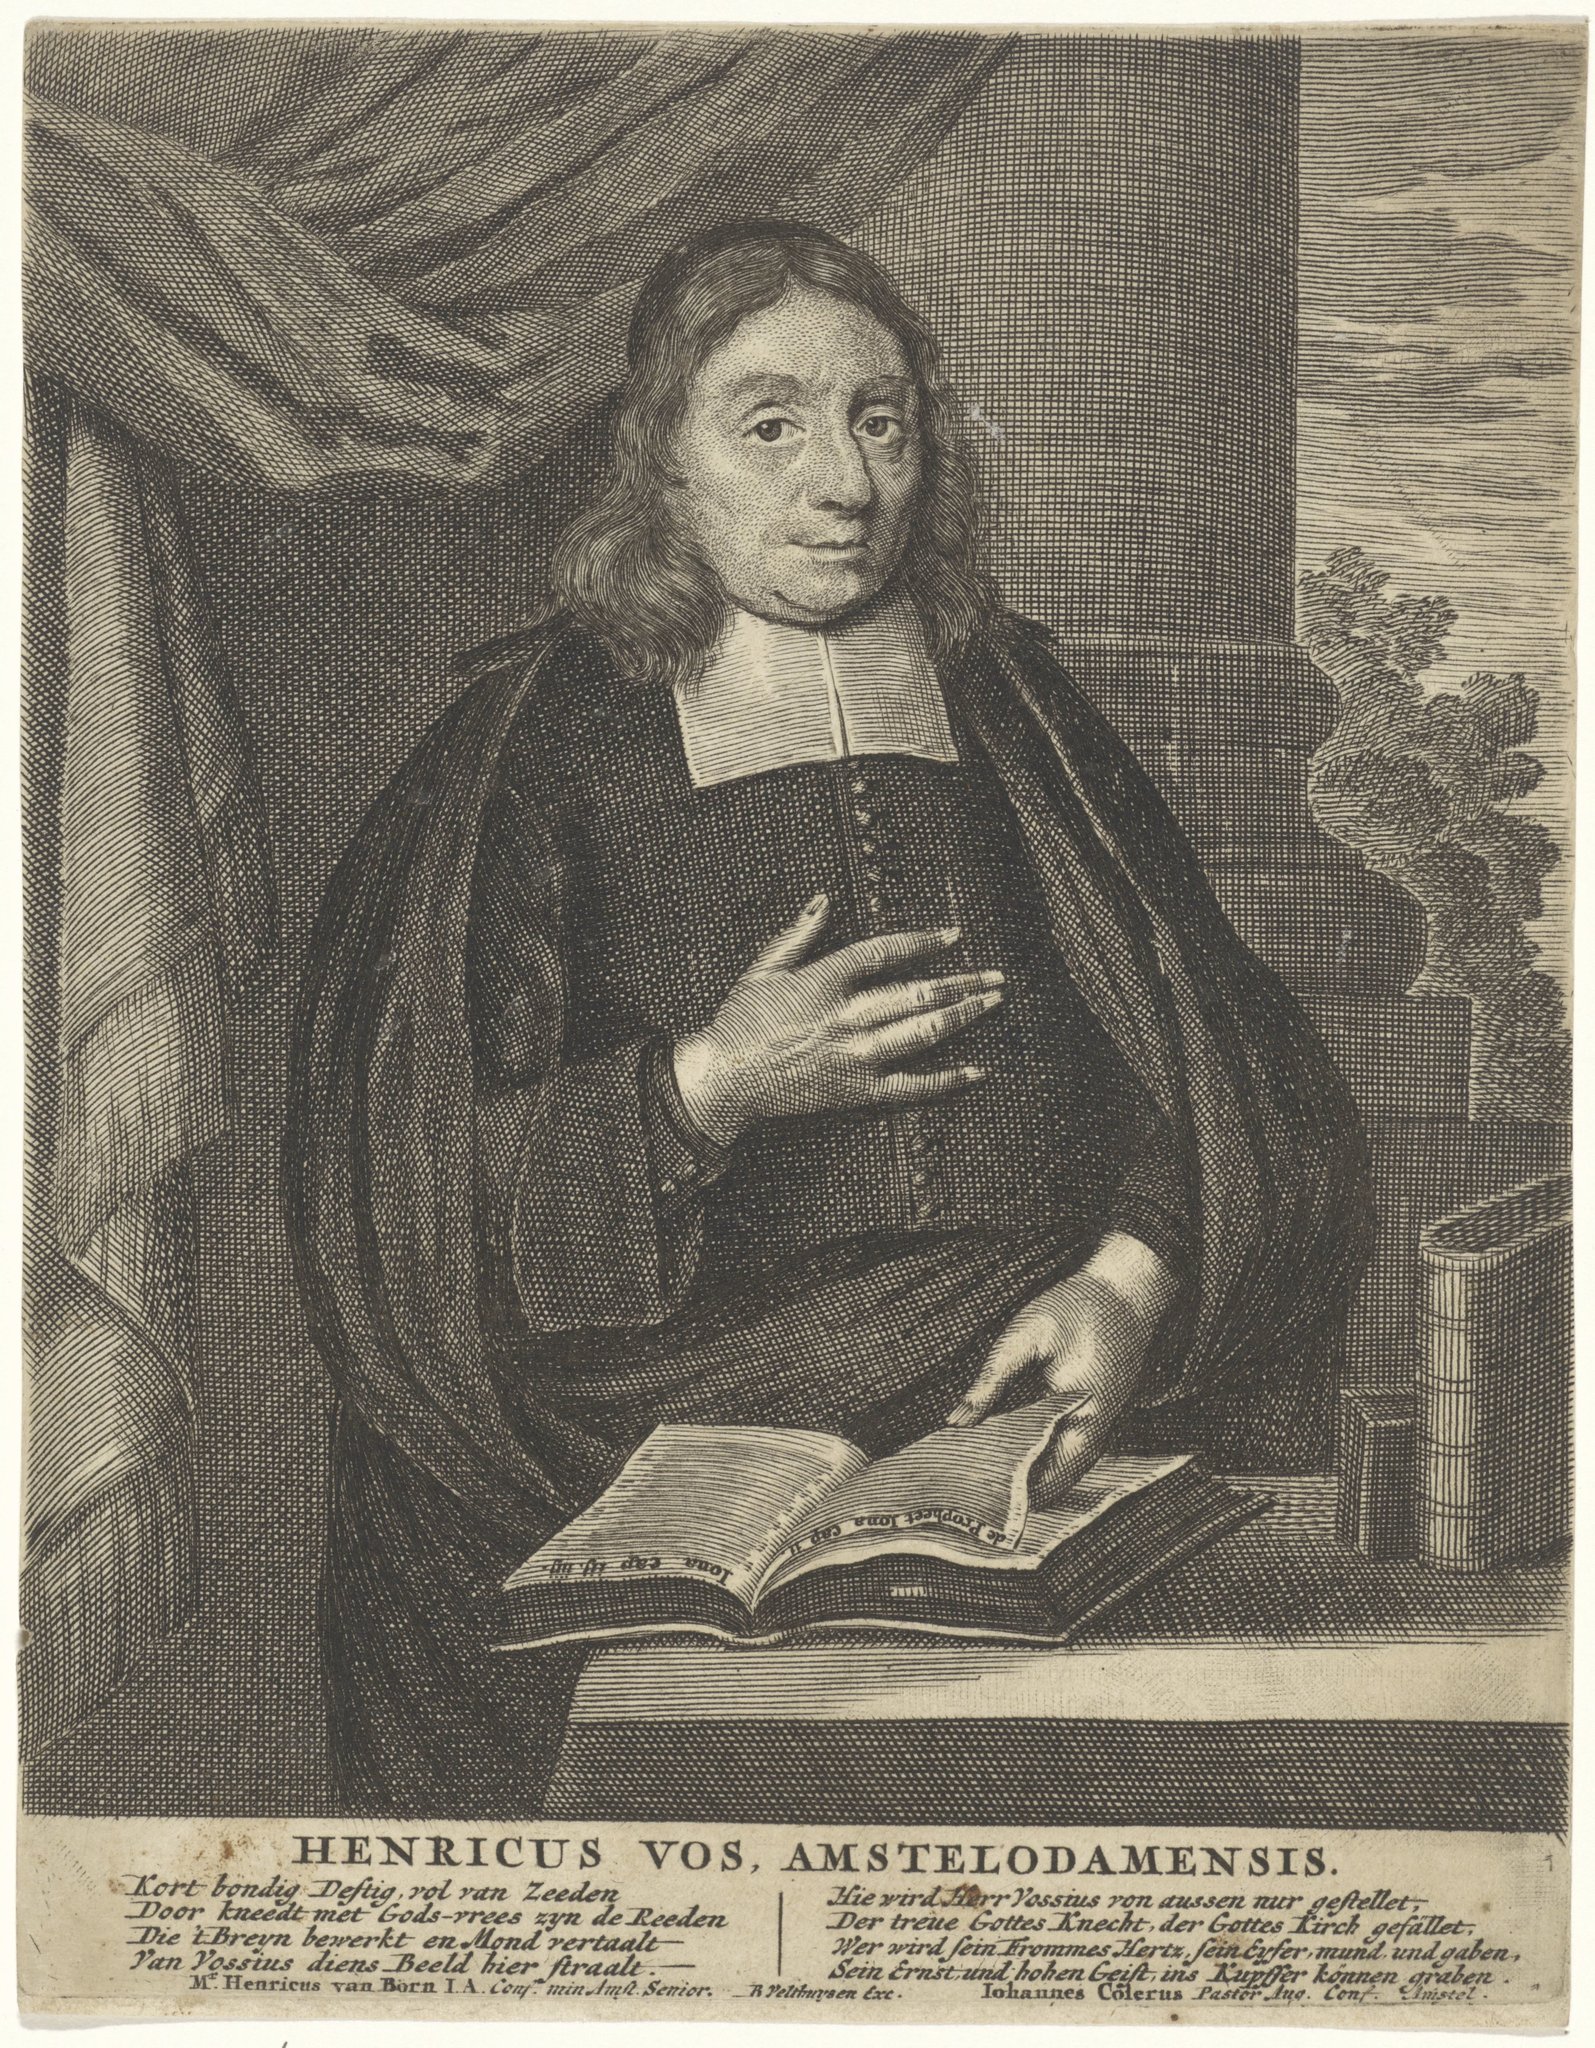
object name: print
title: Portret van de Amsterdamse predikant Henricus Vos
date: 1700-1750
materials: paper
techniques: engraving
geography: amsterdam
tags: amsterdam, henricus vos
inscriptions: collector's mark: Lugt 2228, inscription: ‘G. Storck a Milano 1798./ In.tto. 5383’